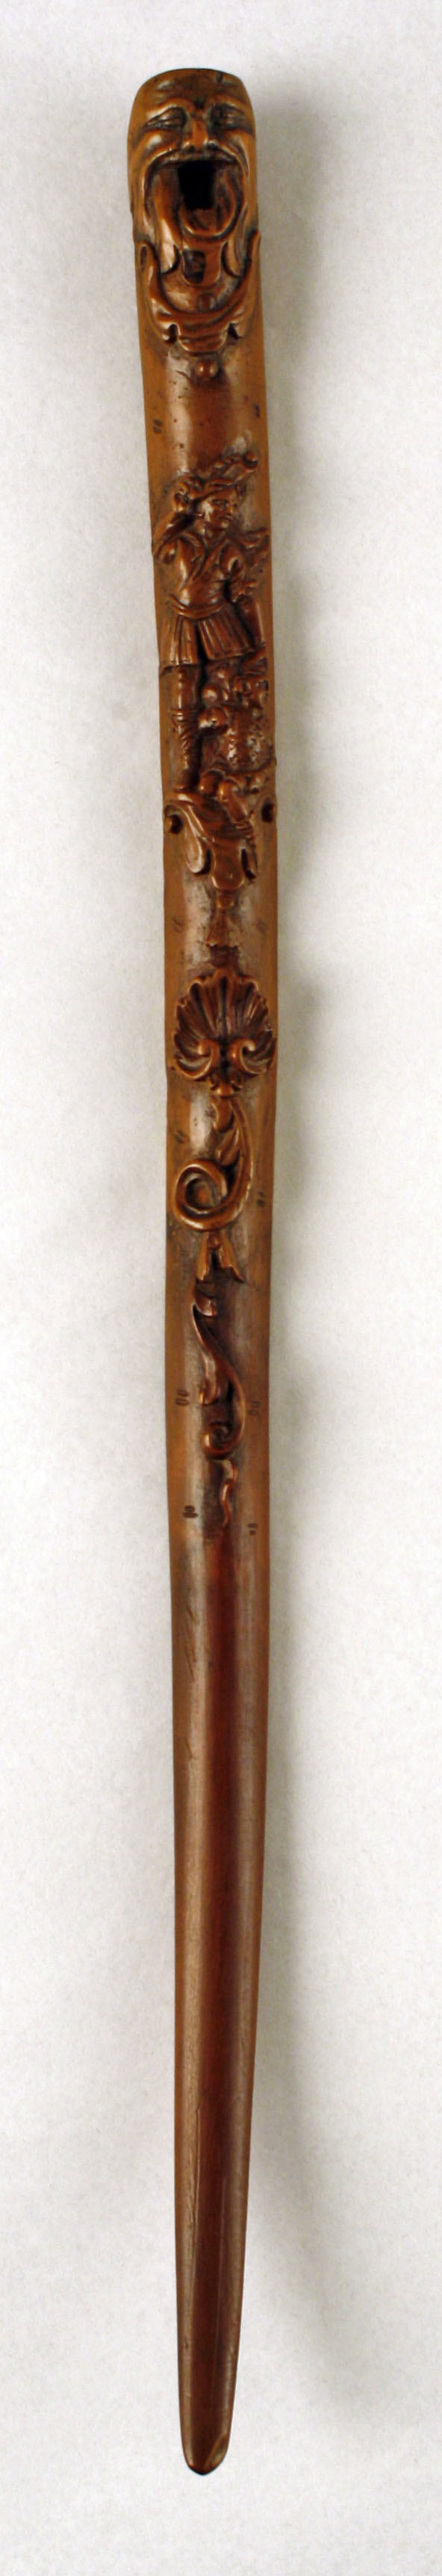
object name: busk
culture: italian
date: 1675-1725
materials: wood